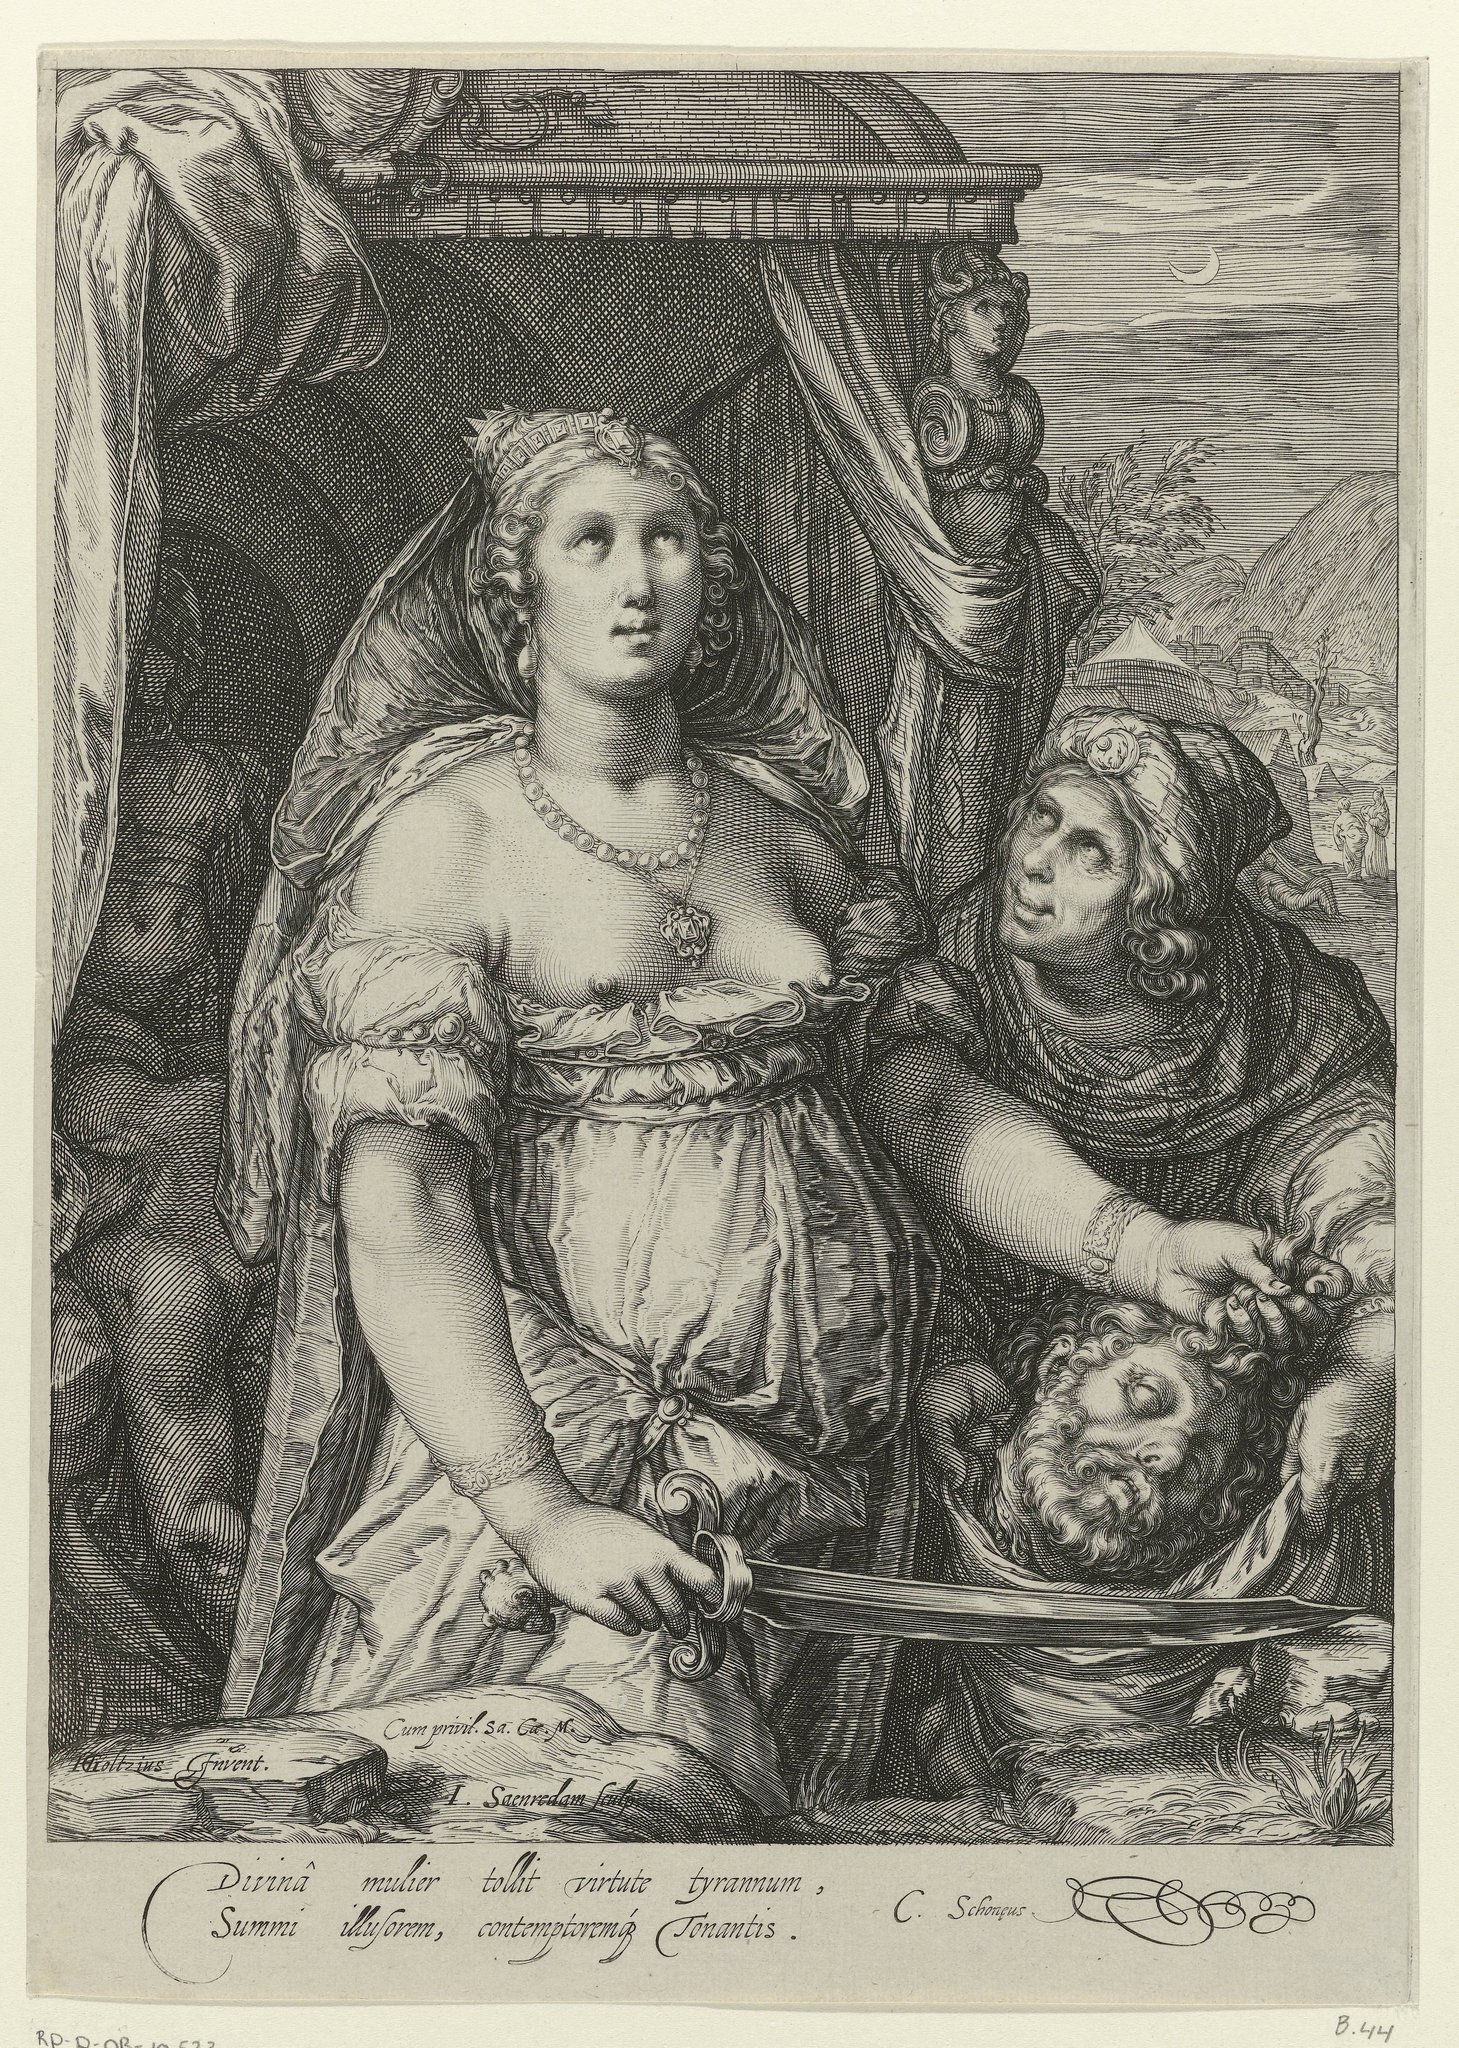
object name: print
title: Judit met het hoofd van Holofernes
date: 1575-1607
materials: paper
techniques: engraving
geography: northern netherlands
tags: judith with holofernes' head and the sword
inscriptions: collector's mark: Lugt 240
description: Judit stopt het pas afgeslagen hoofd van Holofernes in een zak, die wordt open gehouden door haar dienstmaagd. In haar rechterhand het zwaard. Achter haar de onthoofde Holofernes in zijn tent. De prent heeft een Latijns onderschrift.